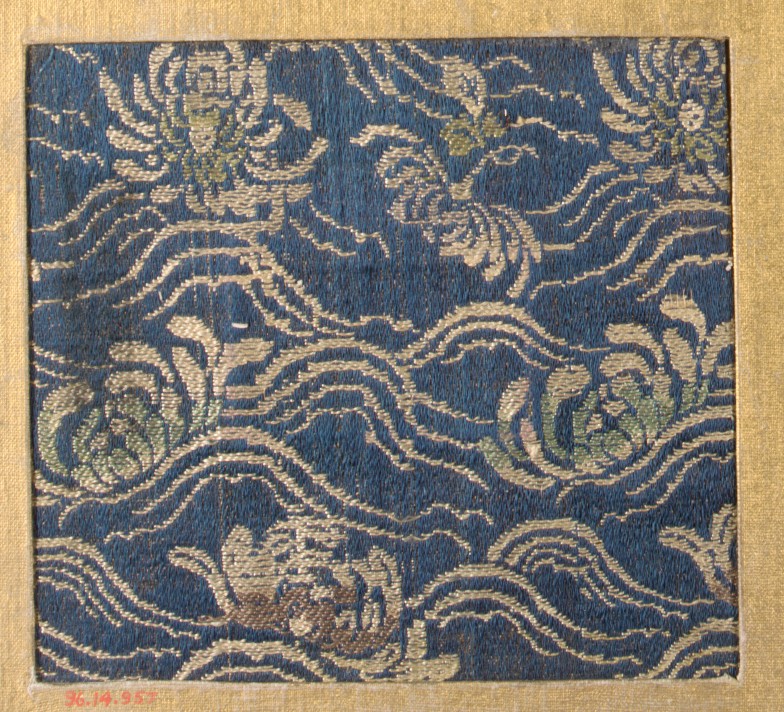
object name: piece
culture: japanese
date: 1701-1900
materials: silk